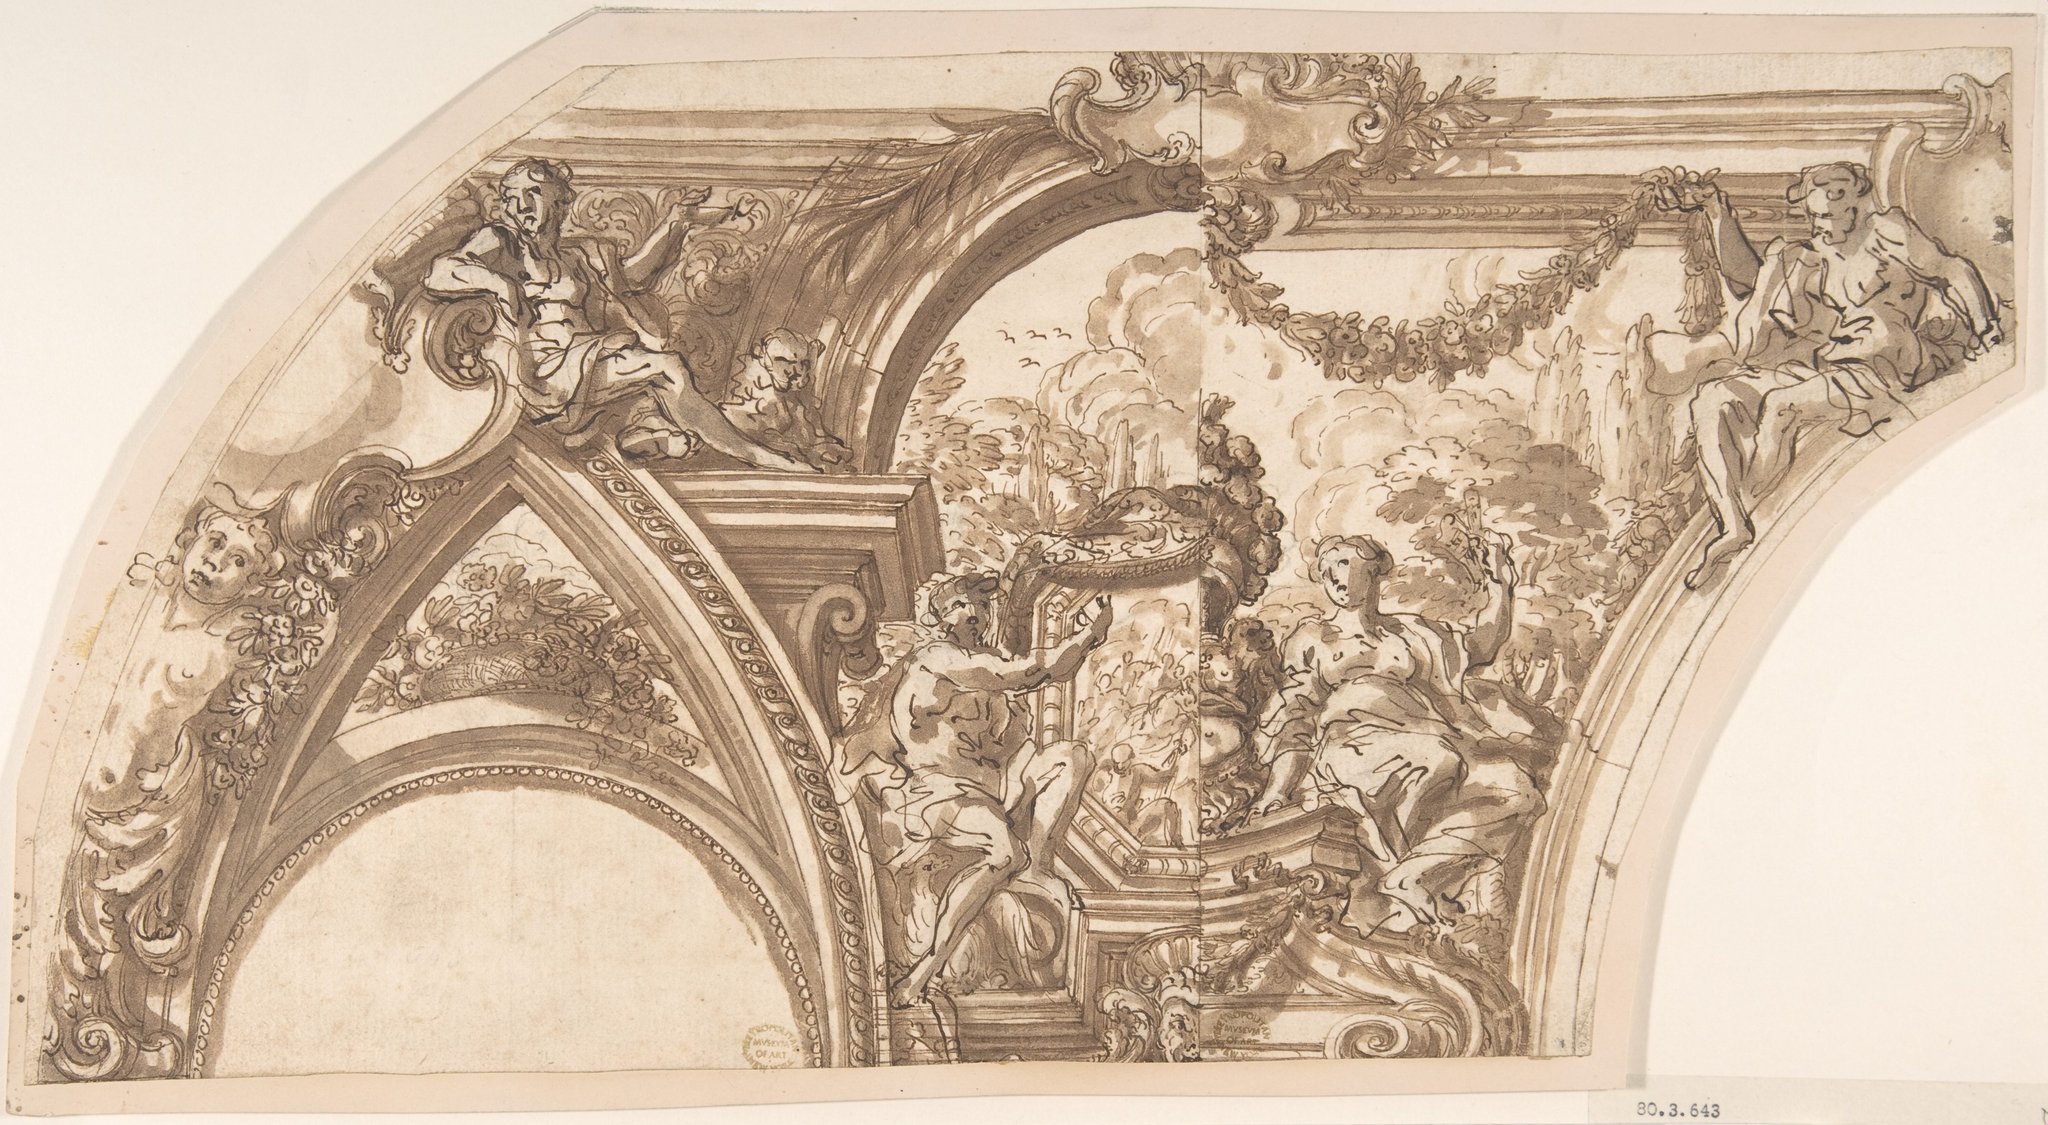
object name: drawing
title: Drawing Showing Two Alternate Designs for a Cove Decoration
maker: anonymous, italian, roman-bolognese, 17th century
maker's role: artist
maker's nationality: italian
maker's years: 1600-1700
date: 1601-1700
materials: chalk, ink, paper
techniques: brush, pen, wash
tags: architecture,garlands,men,women